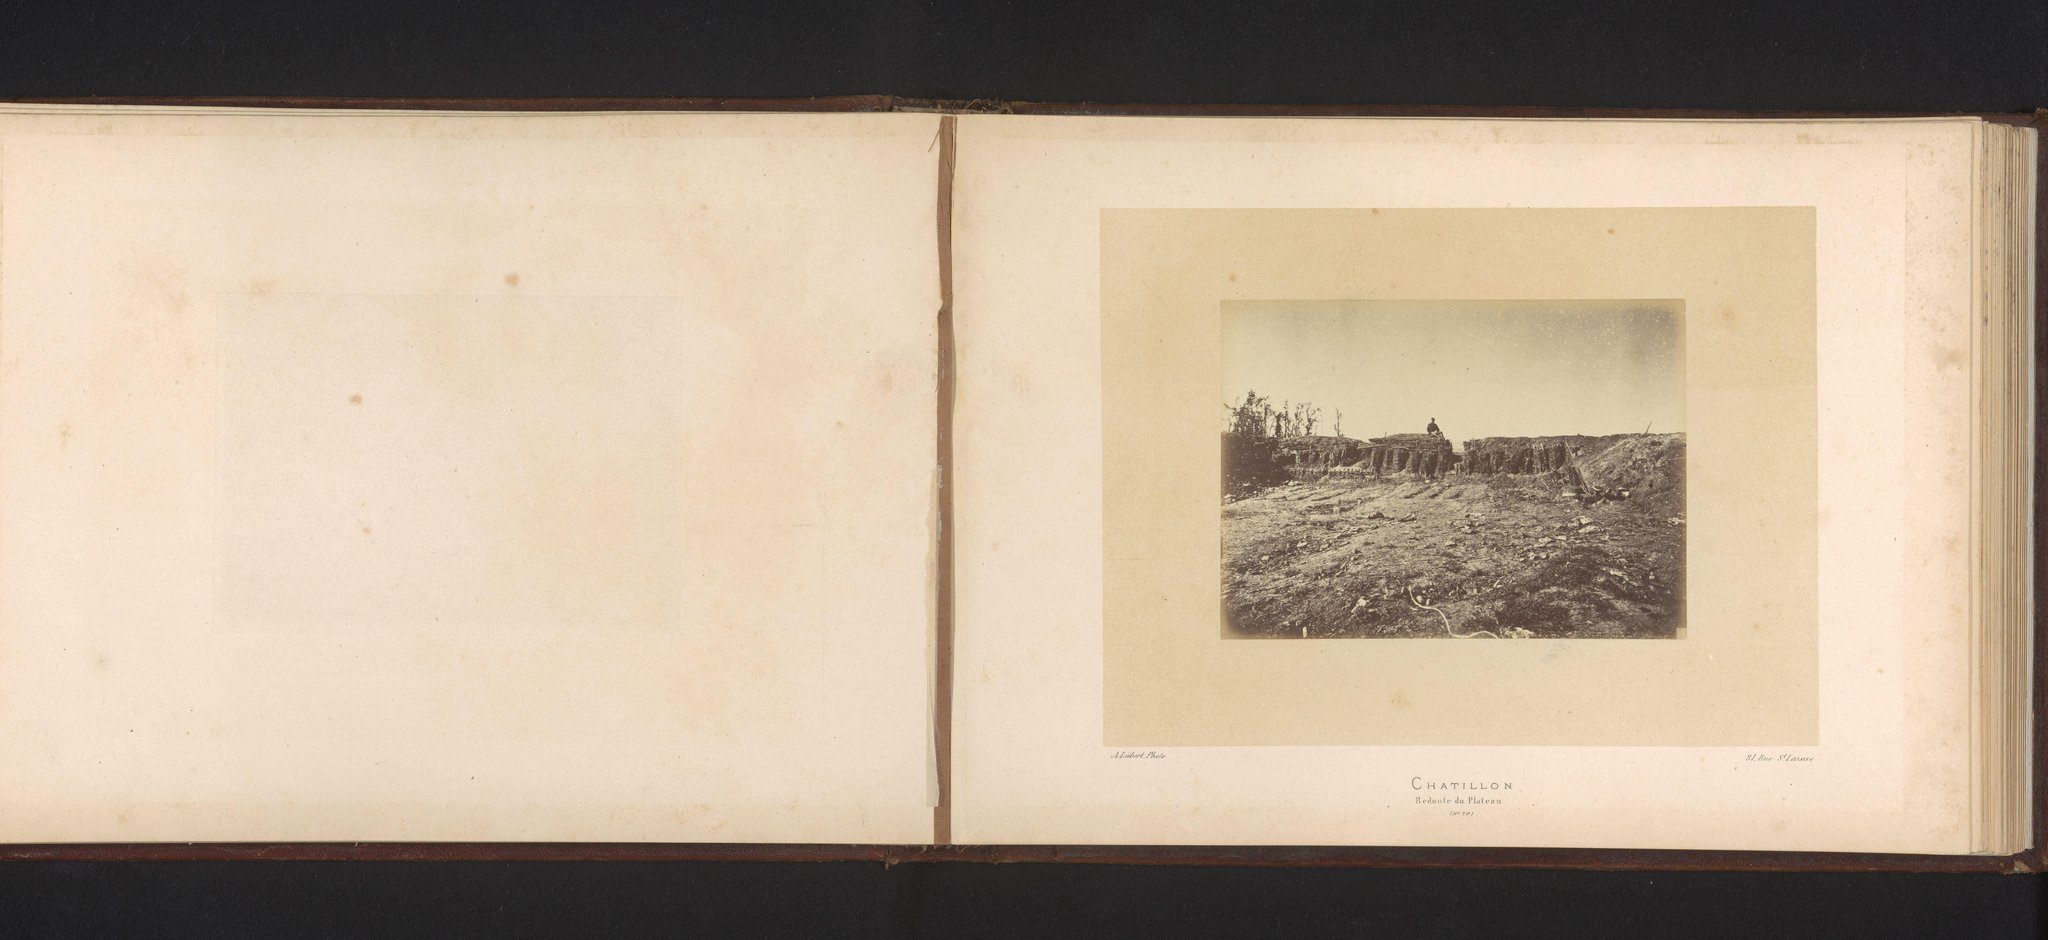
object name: photograph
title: Chatillon. Redoute du Plateau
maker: alphonse-justin liébert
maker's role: fotograaf, marinier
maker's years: 1827-1914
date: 1871-1872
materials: photographic support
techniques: albumen print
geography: châtillon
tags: ruin of a building ~ architecture, obstructions, barricades (defensive measures)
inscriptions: number: ‘(No. 70)’, address: ‘31, Rue St. Lazare’